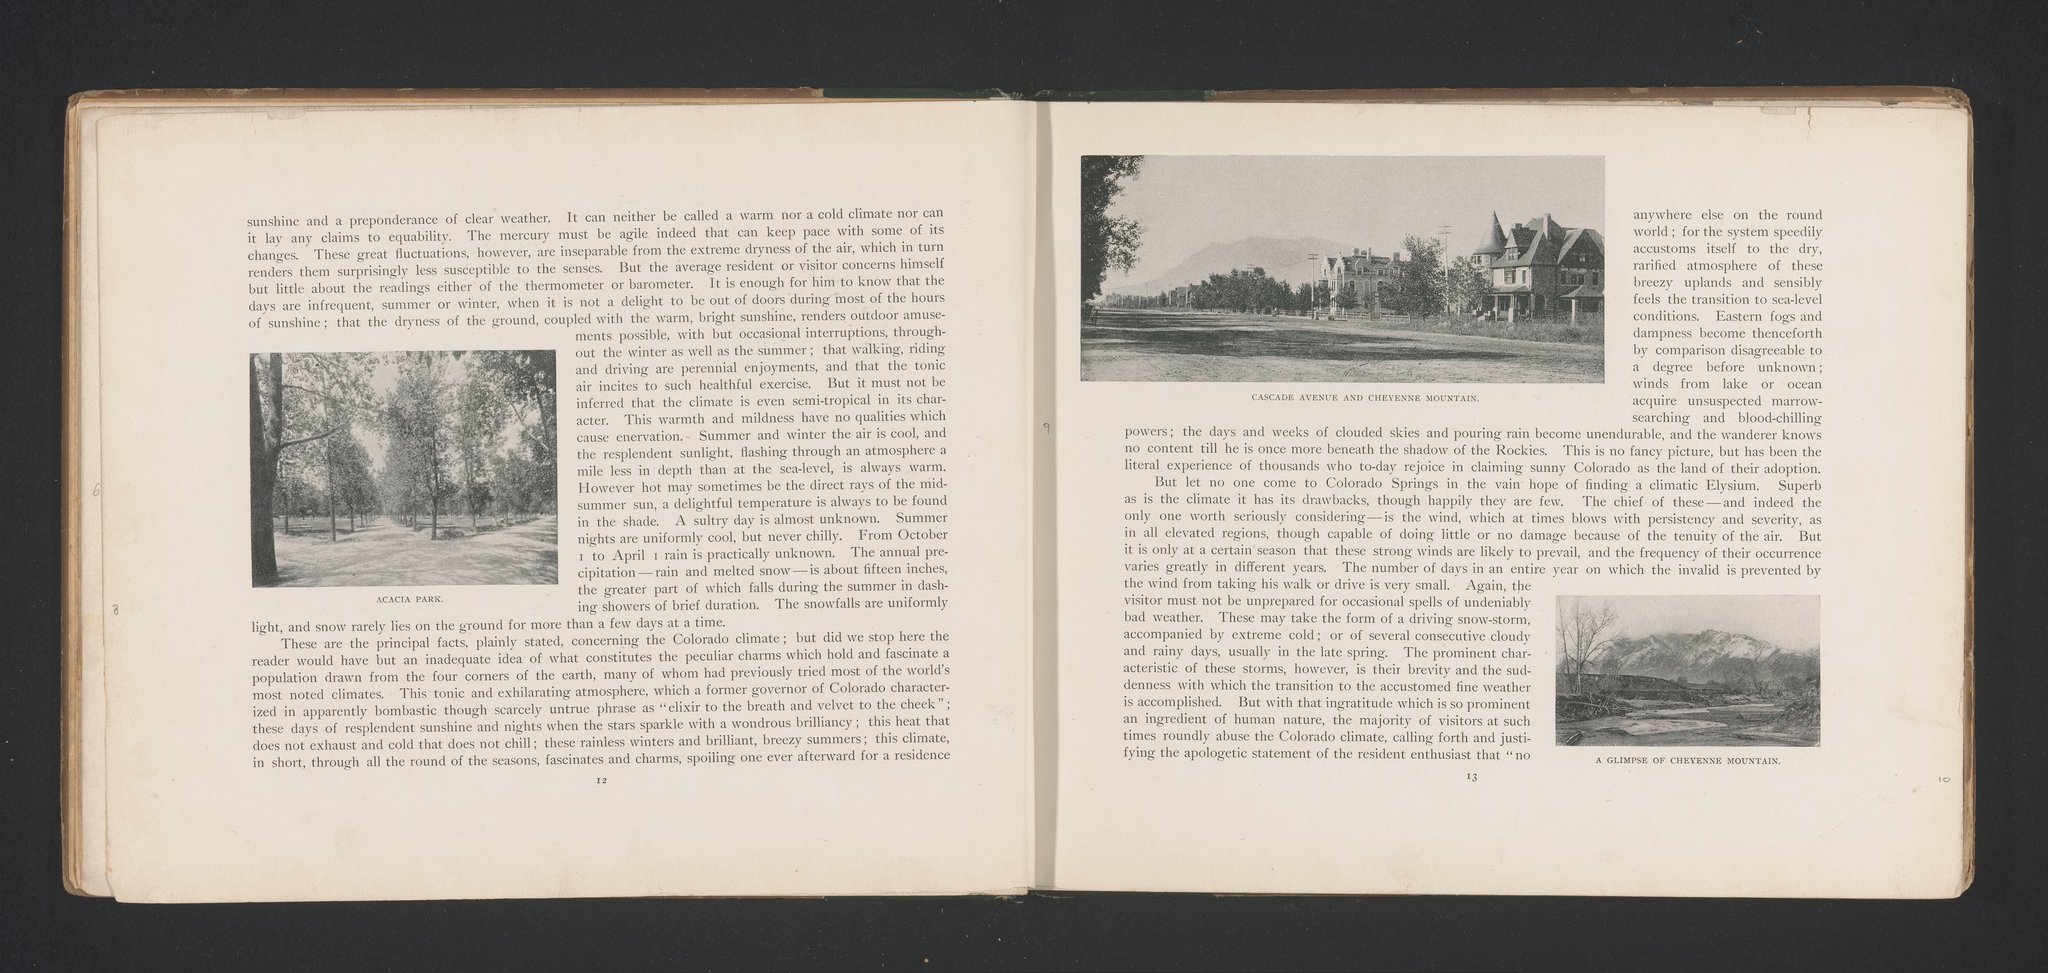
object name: page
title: Gezicht op Acacia Park te Colorado Springs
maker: Anonymous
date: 1888-1893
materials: paper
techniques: autotype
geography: new york city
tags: public gardens, park